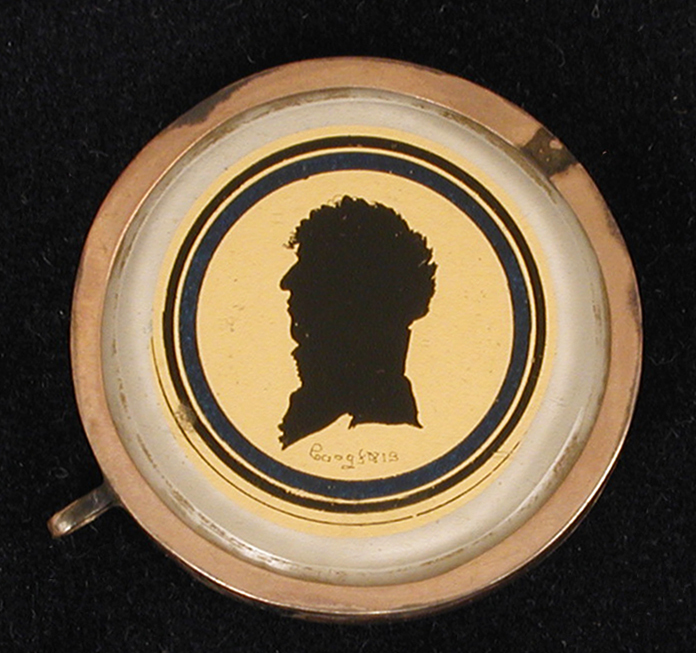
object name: pendant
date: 1813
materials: glass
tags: men,profiles